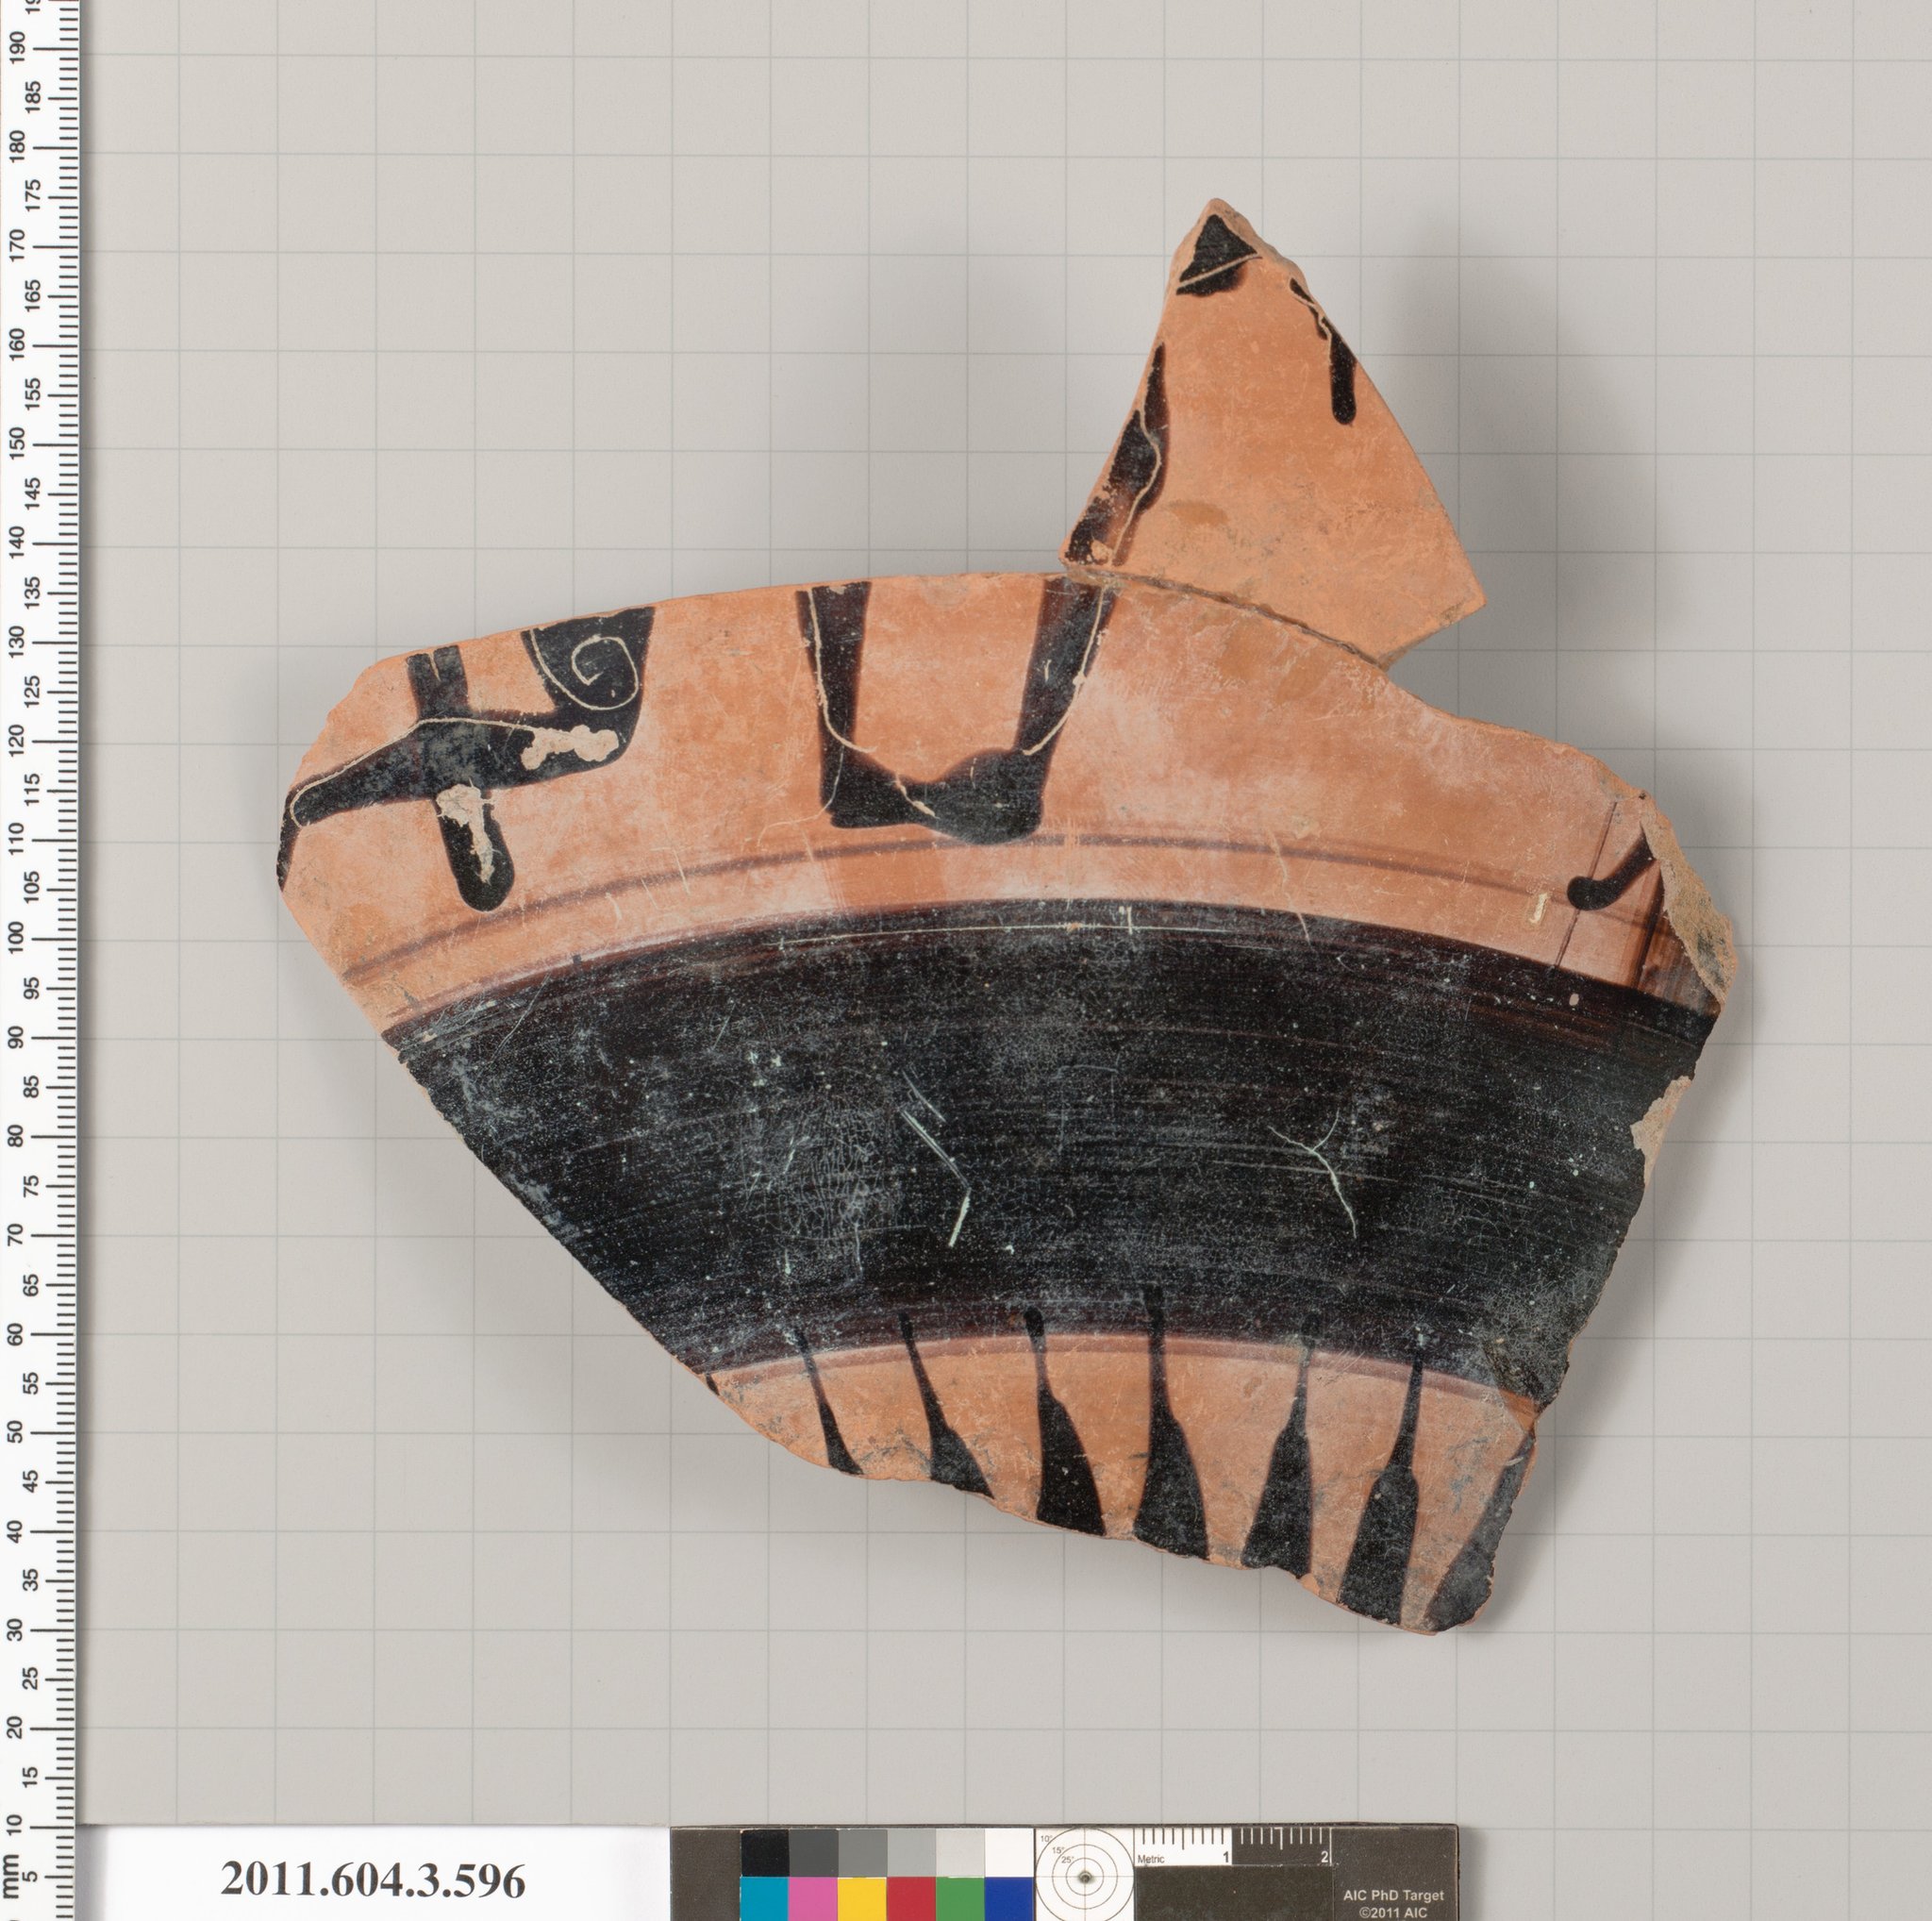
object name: column krater fragment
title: Terracotta fragment of a column-krater (bowl for mixing wine and water)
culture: greek, attic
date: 534-468 BCE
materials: terracotta